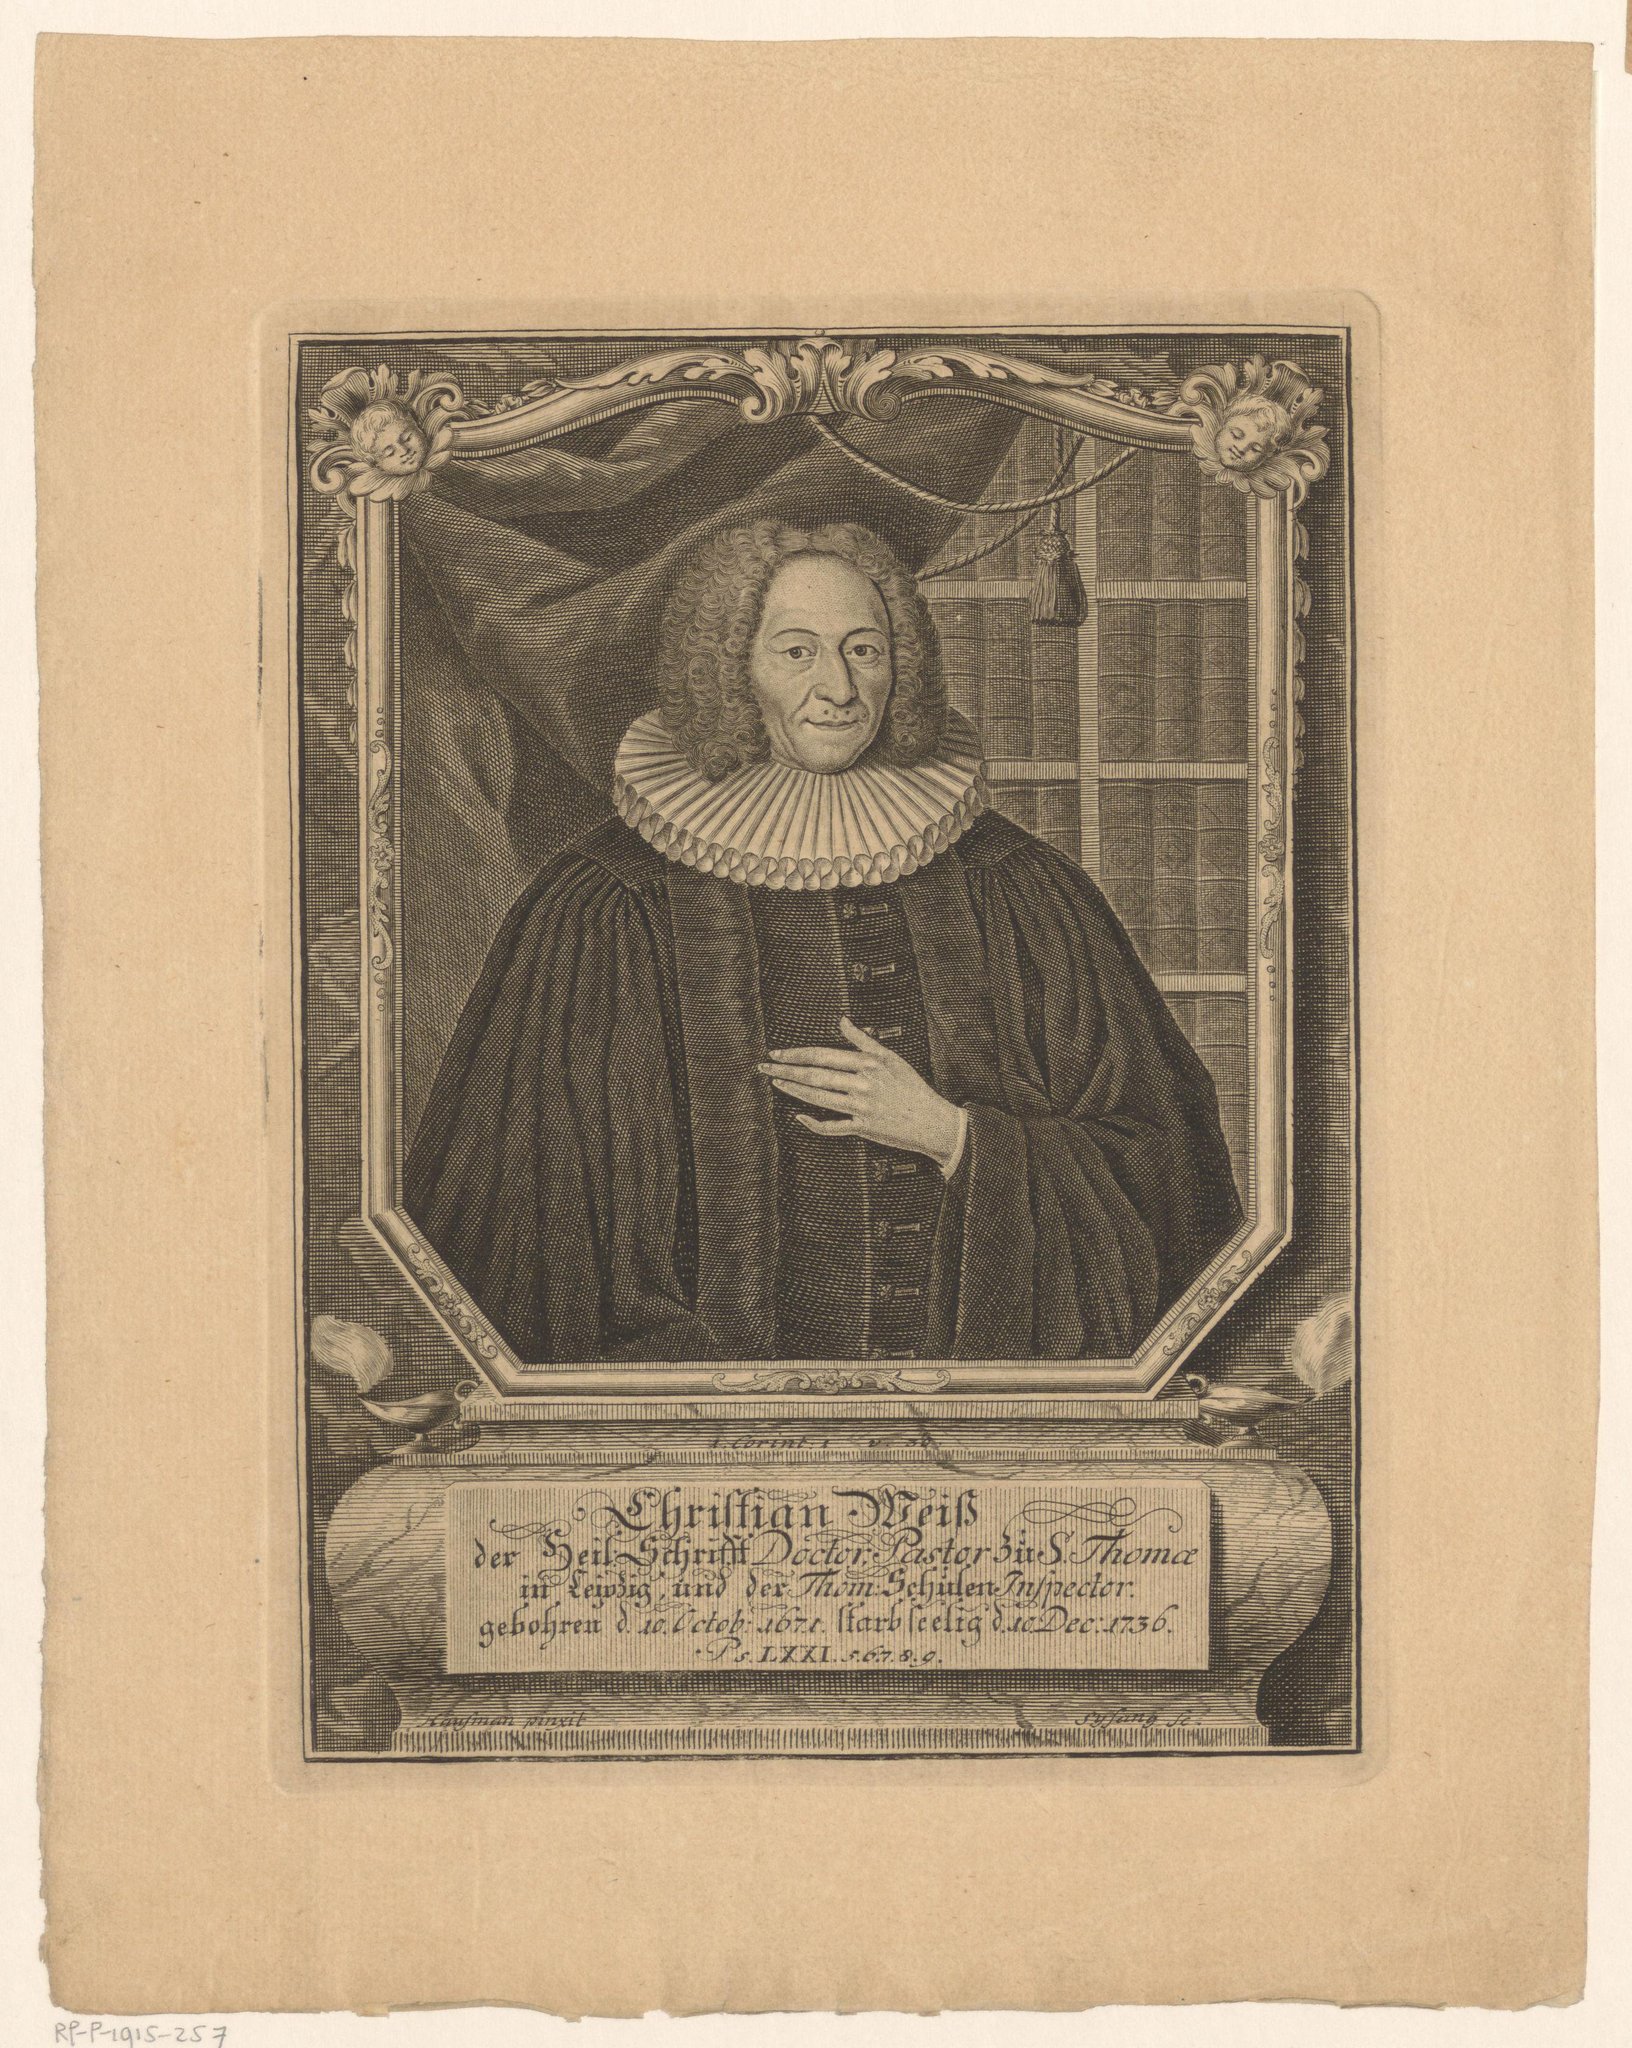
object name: print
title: Portret van Christian Weiß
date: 1736-1757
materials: paper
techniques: engraving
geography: germany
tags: zwickau, clergyman, bookshelves, historical persons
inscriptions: collector's mark: Lugt 2228